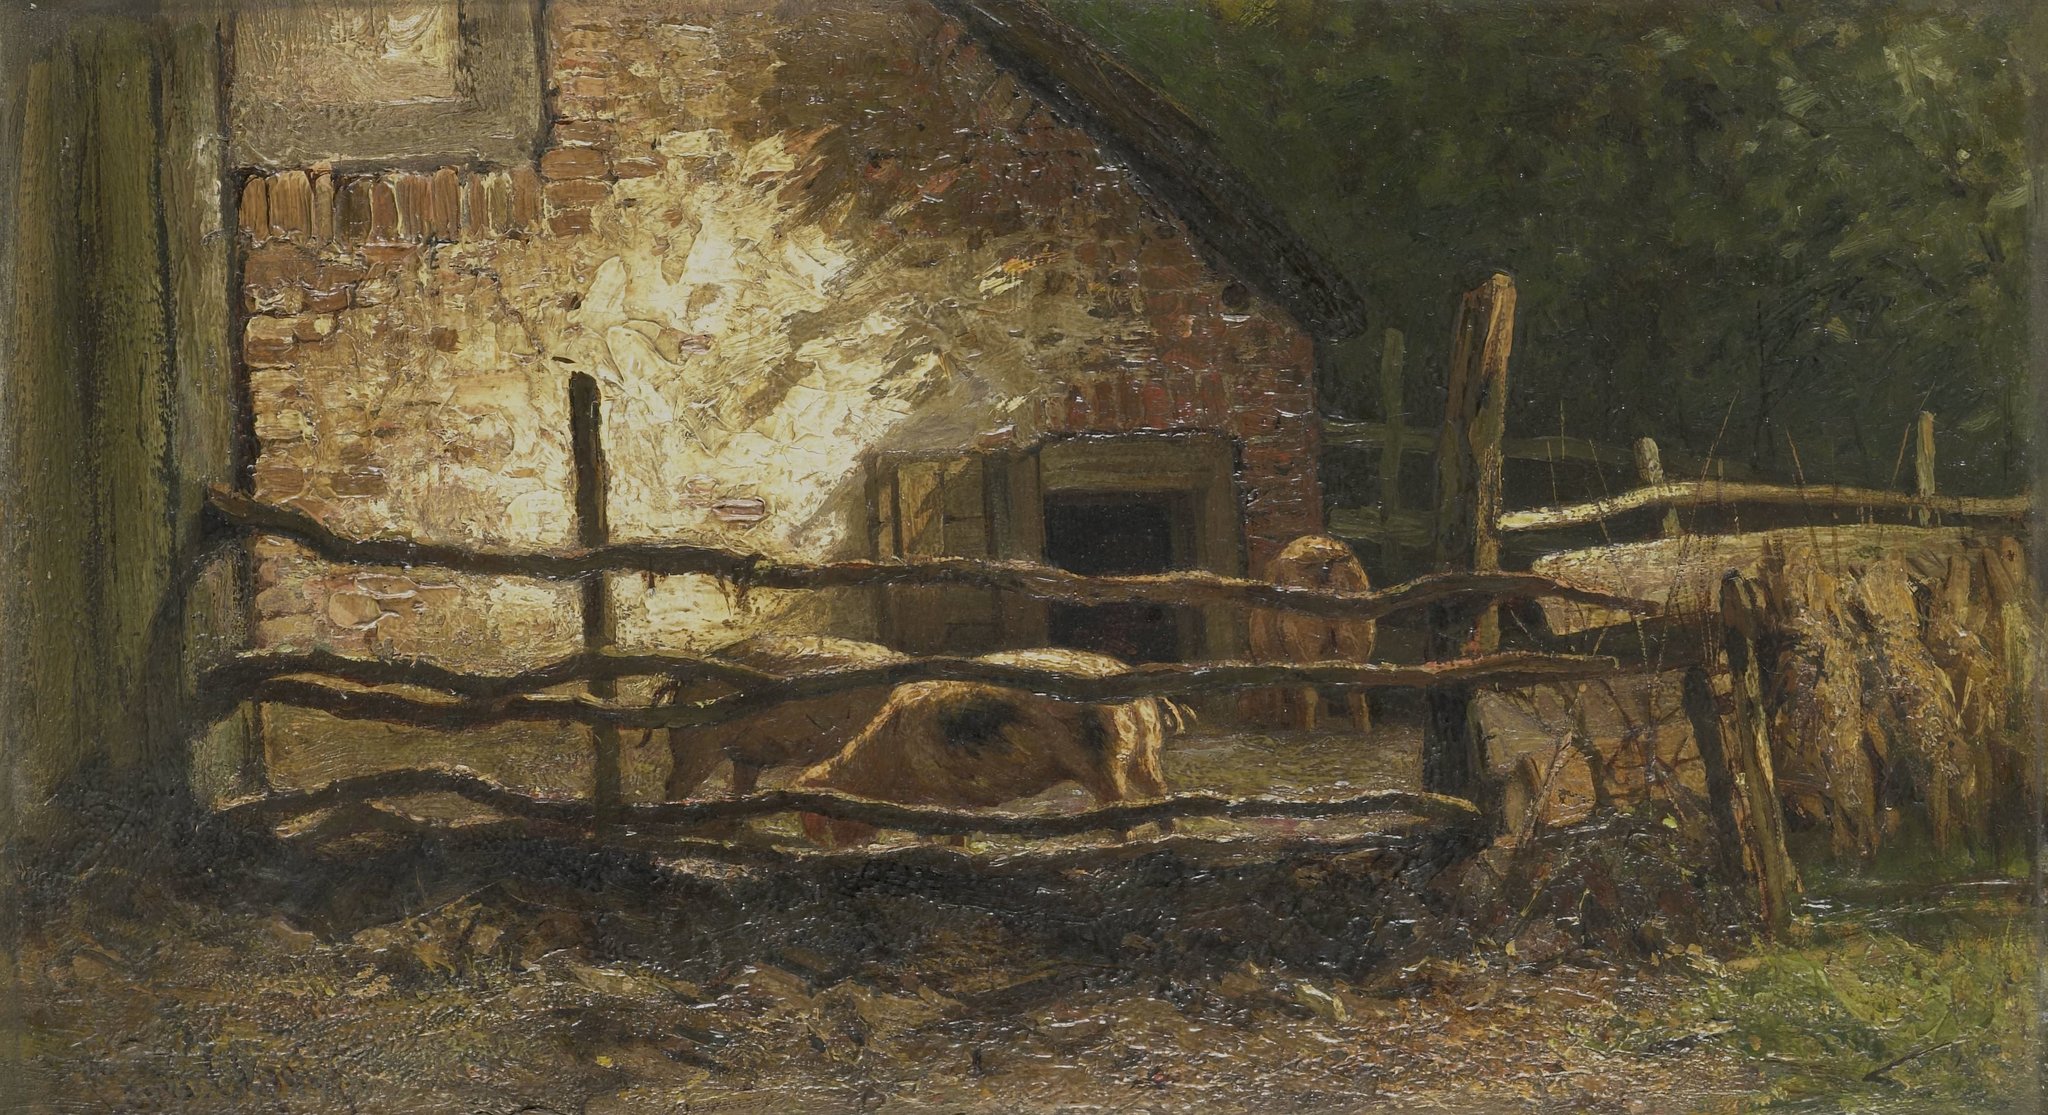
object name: painting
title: Pigs in a Sty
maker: louis apol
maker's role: draughtsman, painter, print maker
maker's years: 1850-1936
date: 1870-1910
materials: oil, panel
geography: netherlands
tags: pig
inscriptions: signature: ‘Louis Apol f’